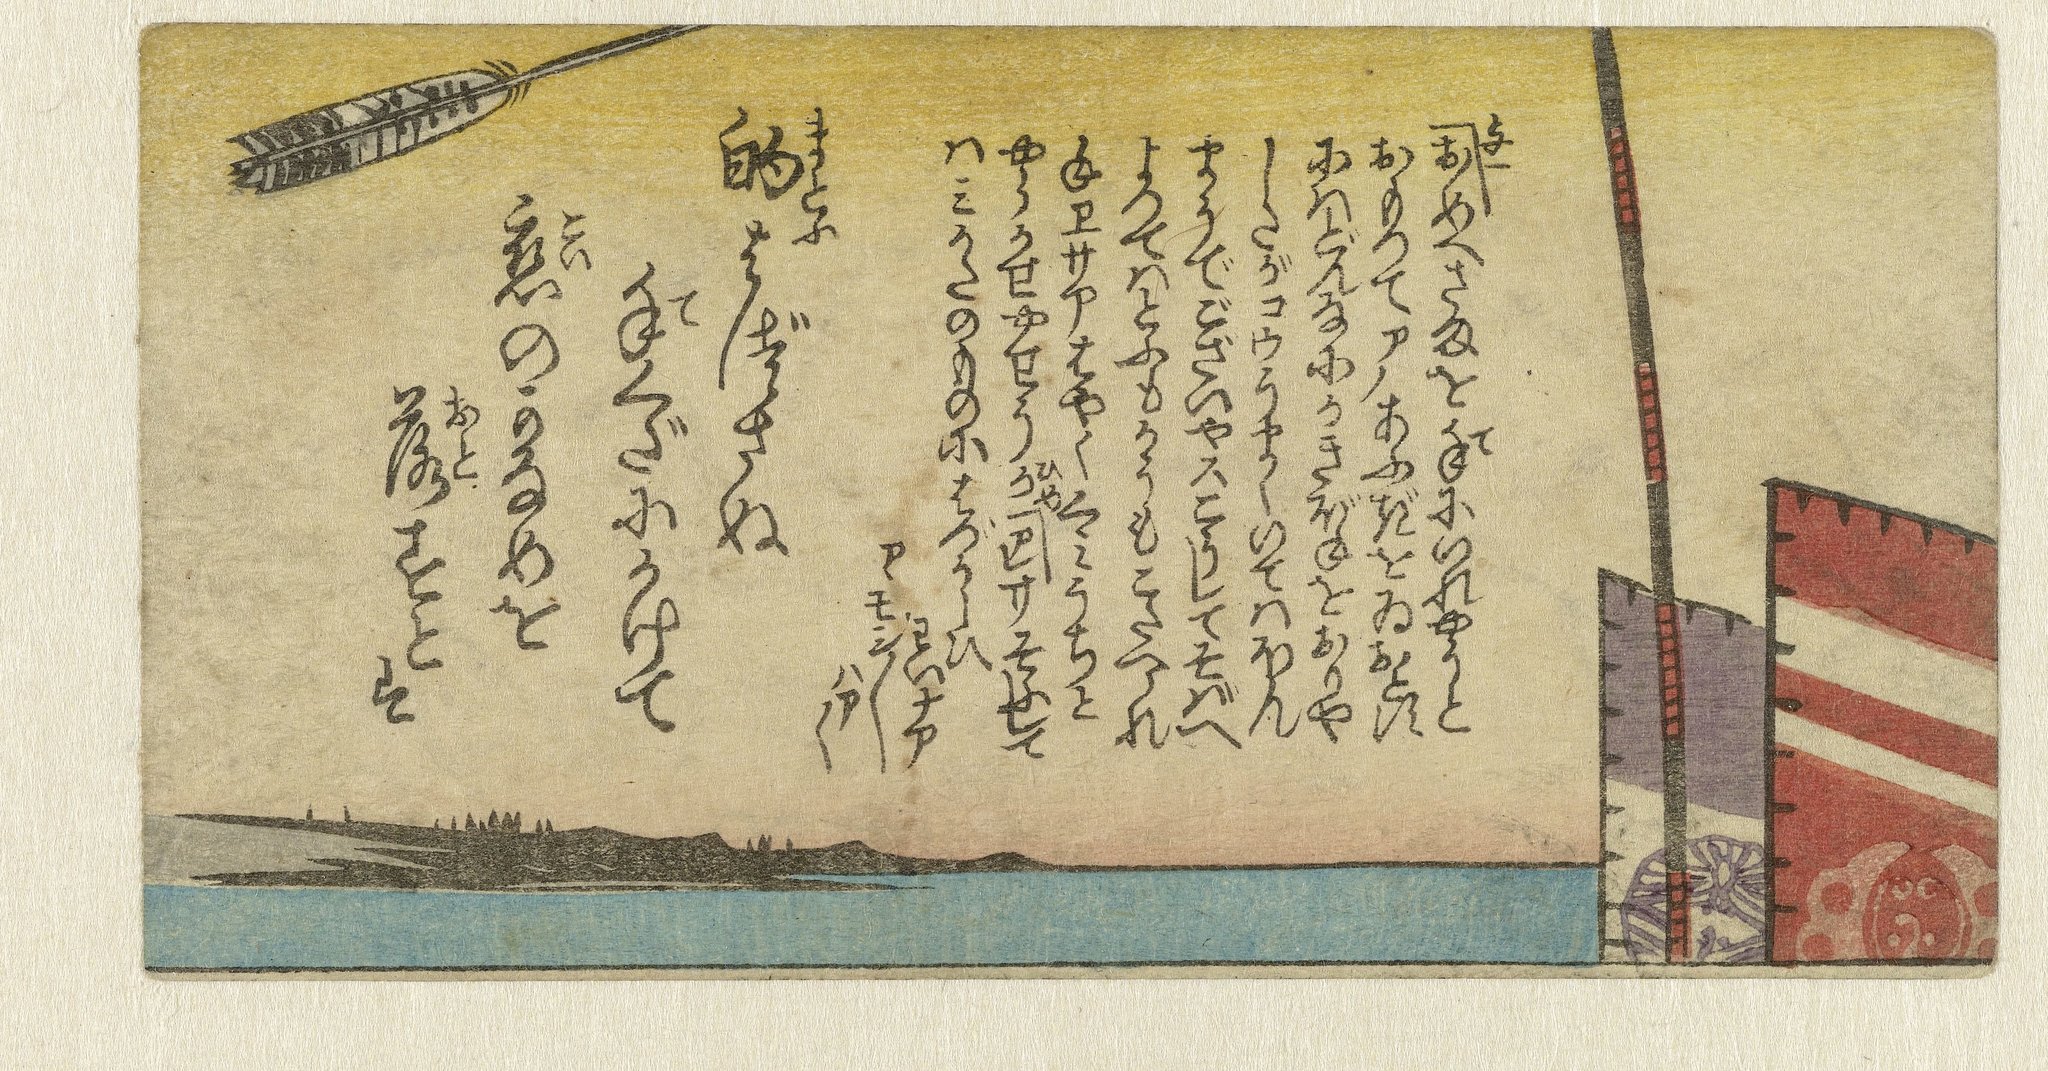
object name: print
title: Waaierserie met begeleidende prenten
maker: Anonymous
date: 1850-1860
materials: paper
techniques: woodcut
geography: japan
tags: archer's weapons: arrow, banner, standard (as symbol of the state, etc.), oriental ideographic script (chinese, korean, japanese)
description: Vaandels en de schacht van een pijl, met een begleidende tekst bij de 'militaire waaier'.